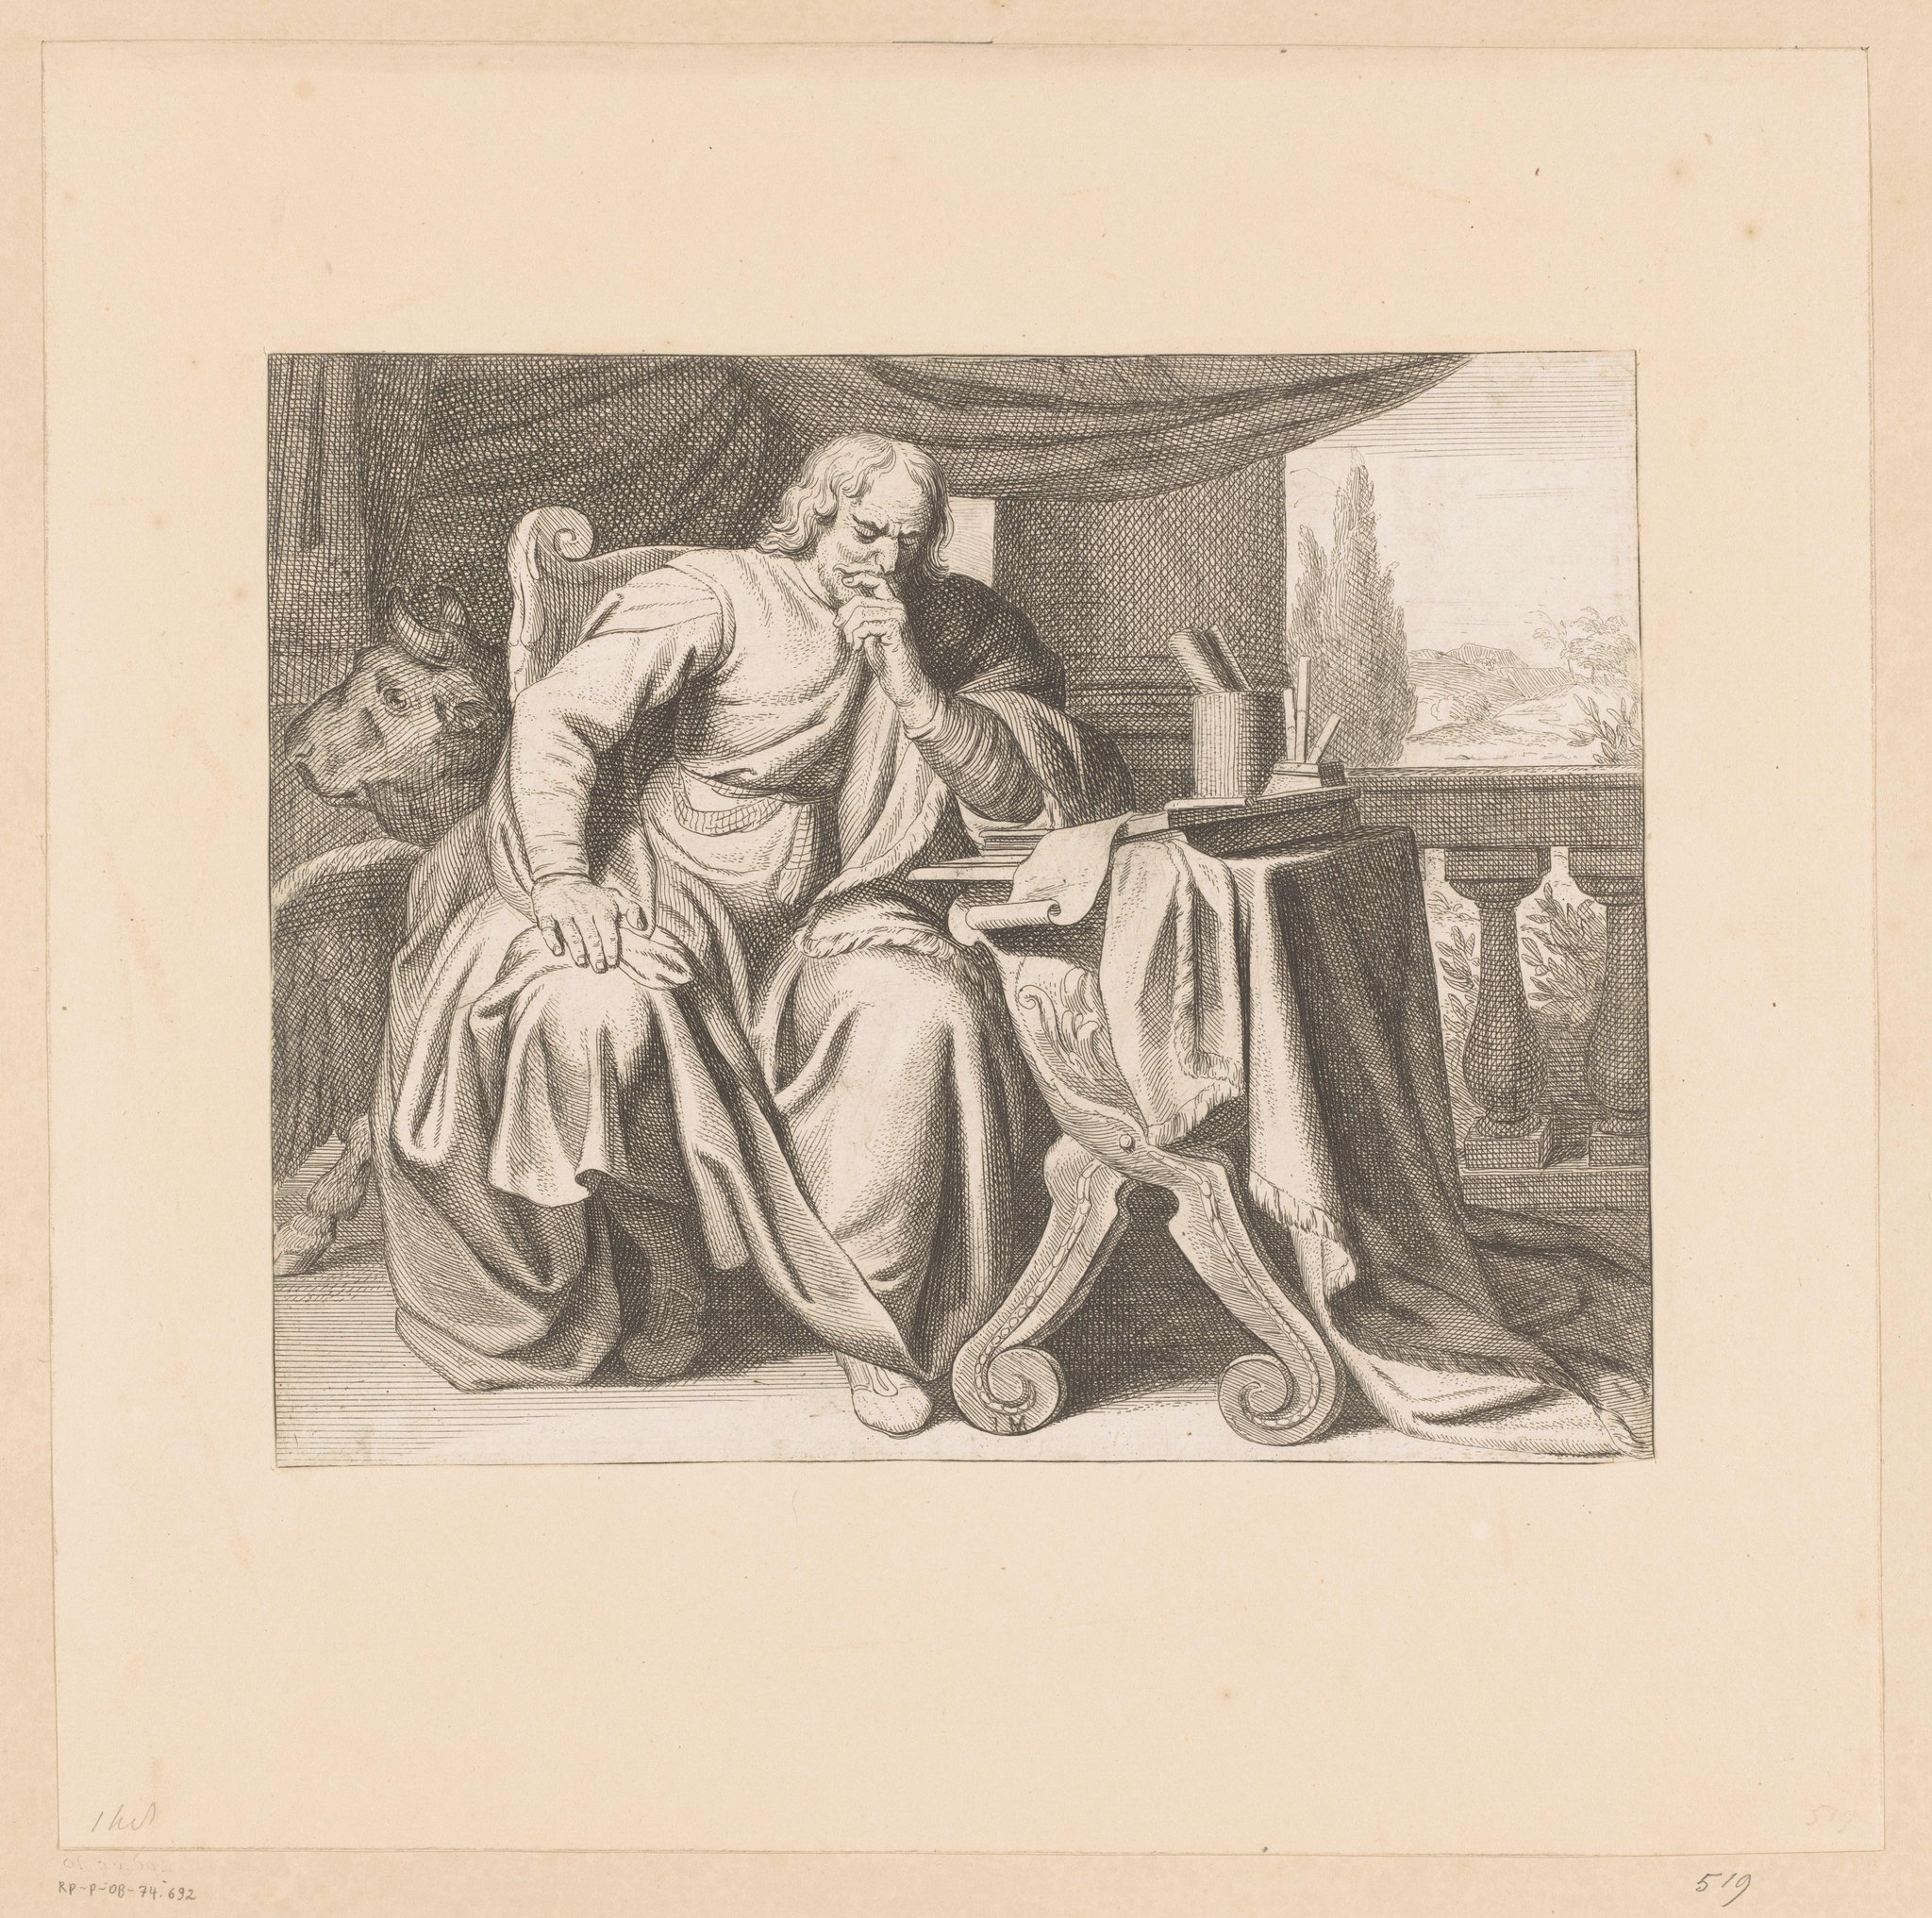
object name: print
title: Vier evangelisten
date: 1600-1630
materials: paper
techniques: engraving, etching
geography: france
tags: ox (possibly with book) ~ symbol of st. luke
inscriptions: collector's mark: Lugt 240